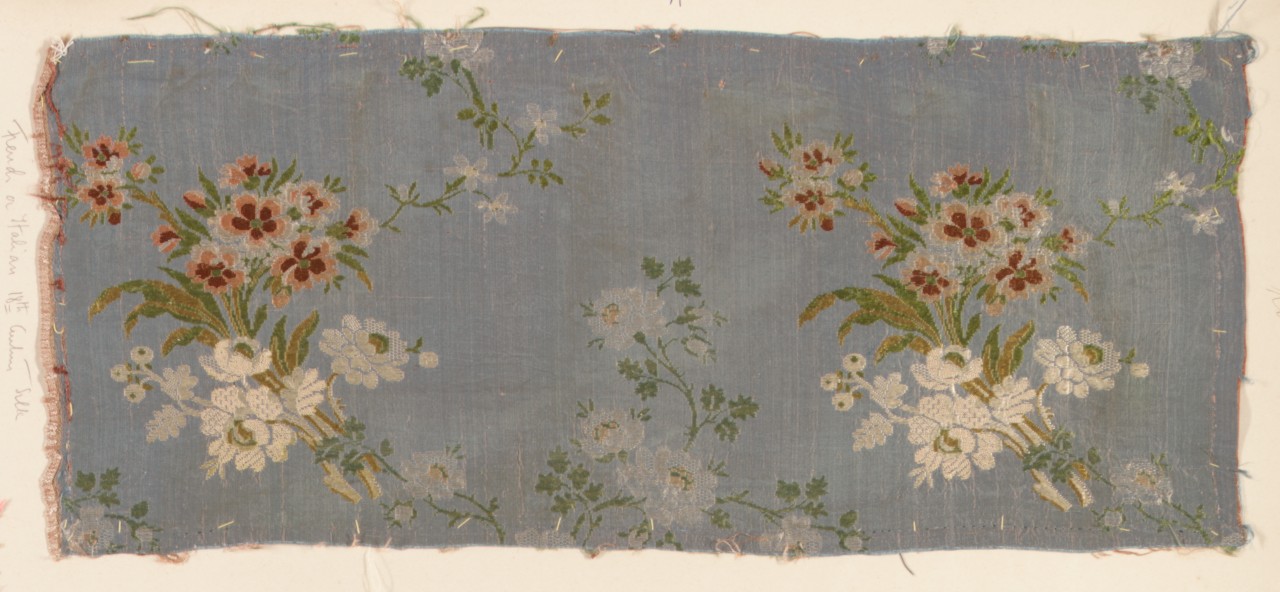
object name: fragment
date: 1701-1800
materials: silk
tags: flowers,leaves